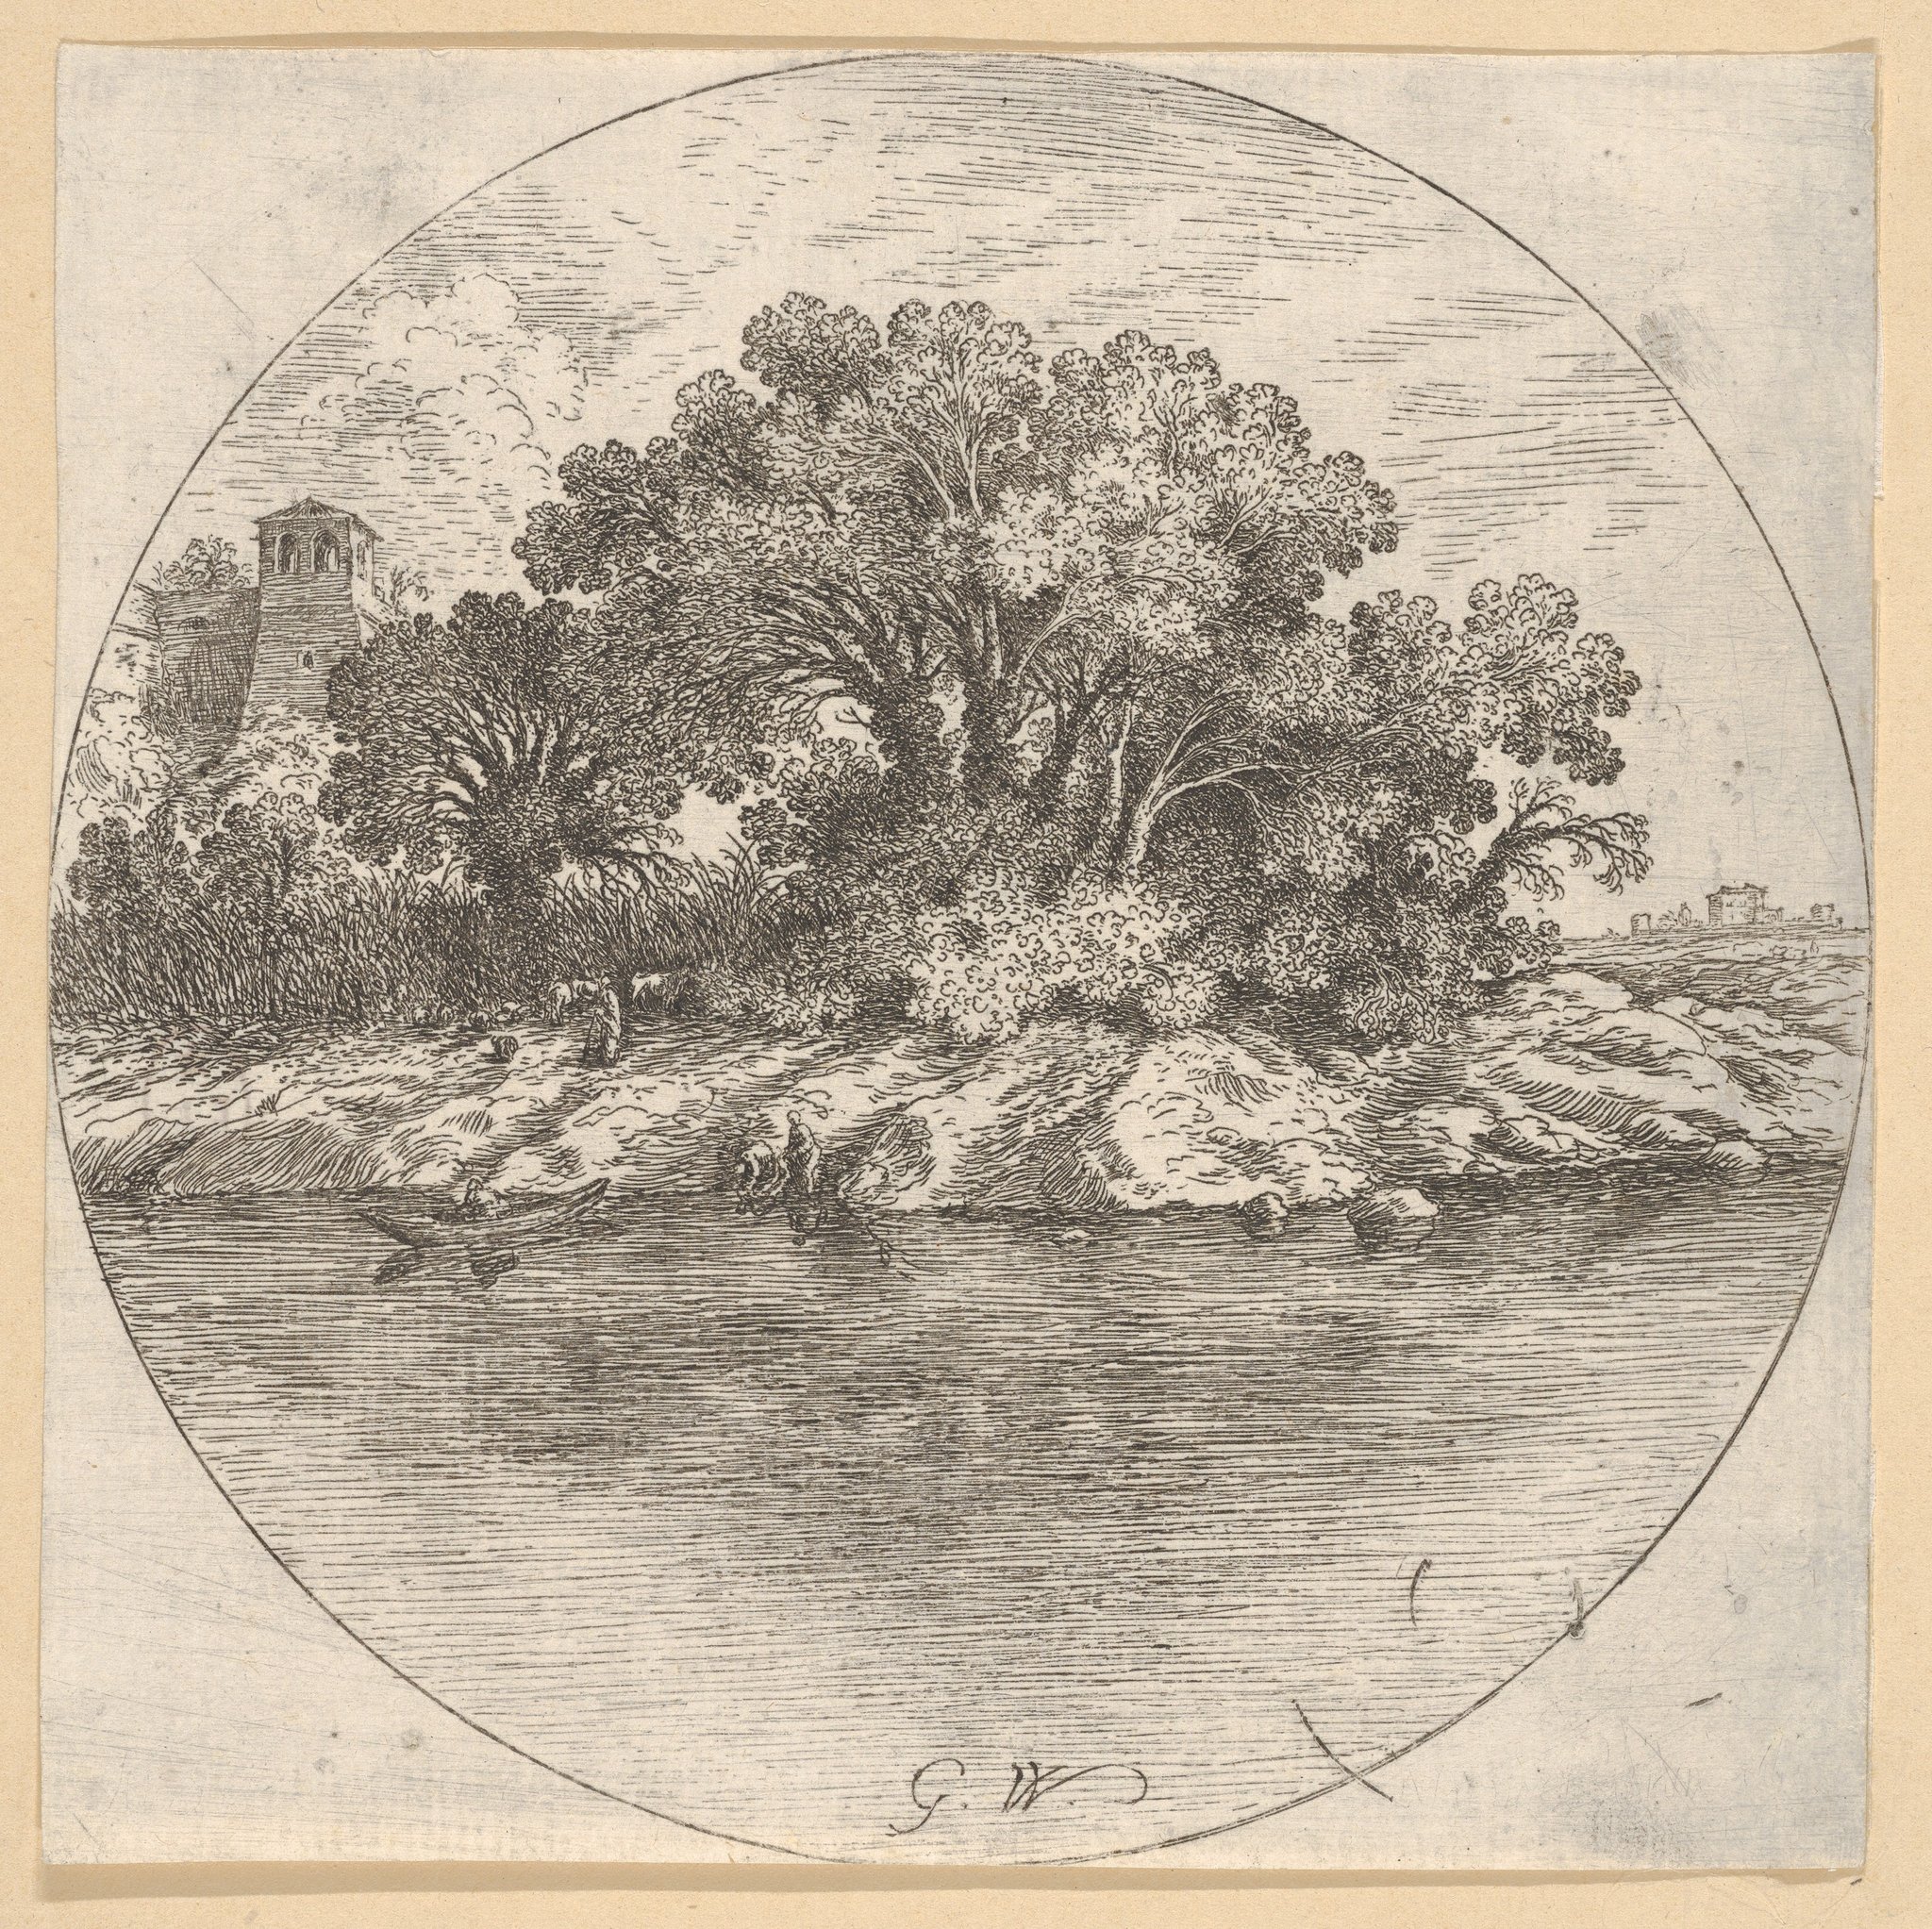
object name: print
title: Landscape with Trees by the Water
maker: goffredo wals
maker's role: artist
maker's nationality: german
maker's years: 1590-1640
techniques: etching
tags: landscapes